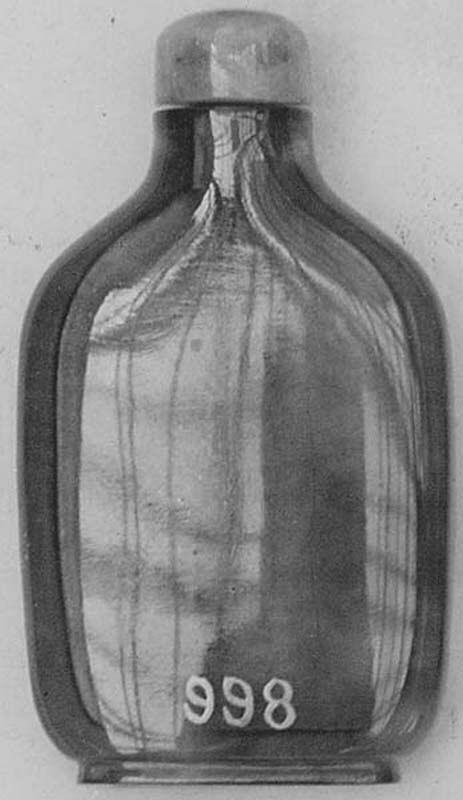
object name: snuff bottle with stopper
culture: chinese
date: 1701-1900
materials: amber, jade